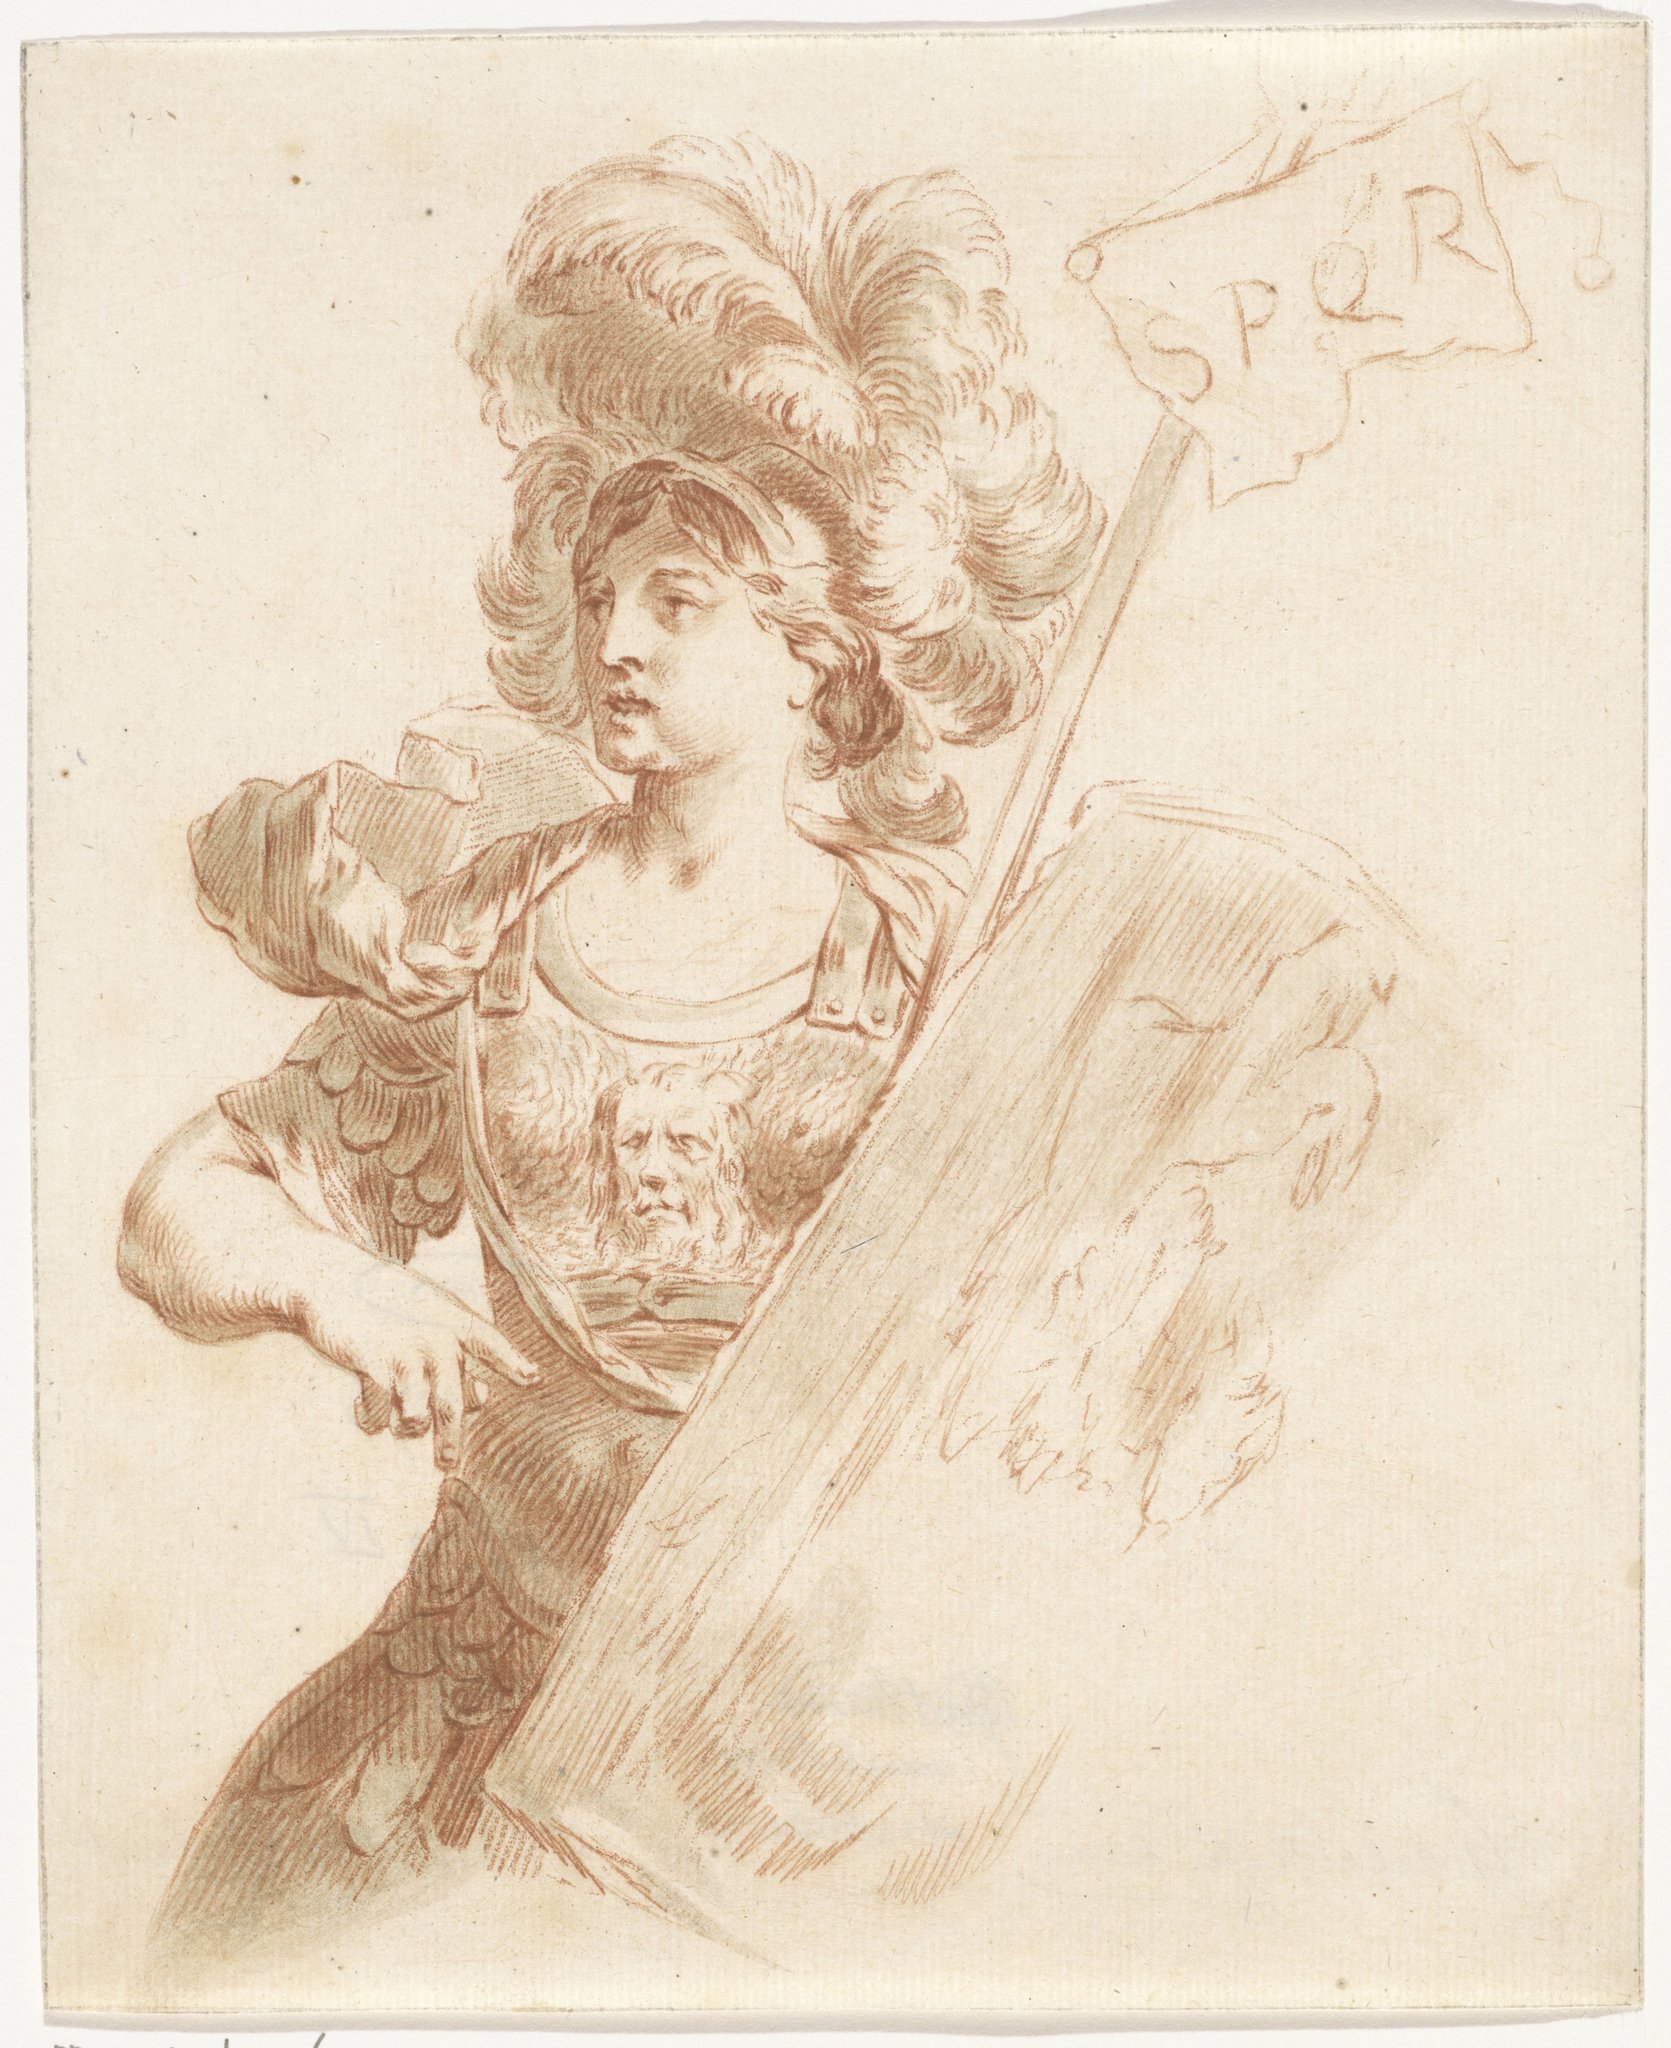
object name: print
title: Minerva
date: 1754-1809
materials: paper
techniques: printing, printmaking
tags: (story of) minerva (pallas, athena)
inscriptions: collector's mark: Lugt 2228